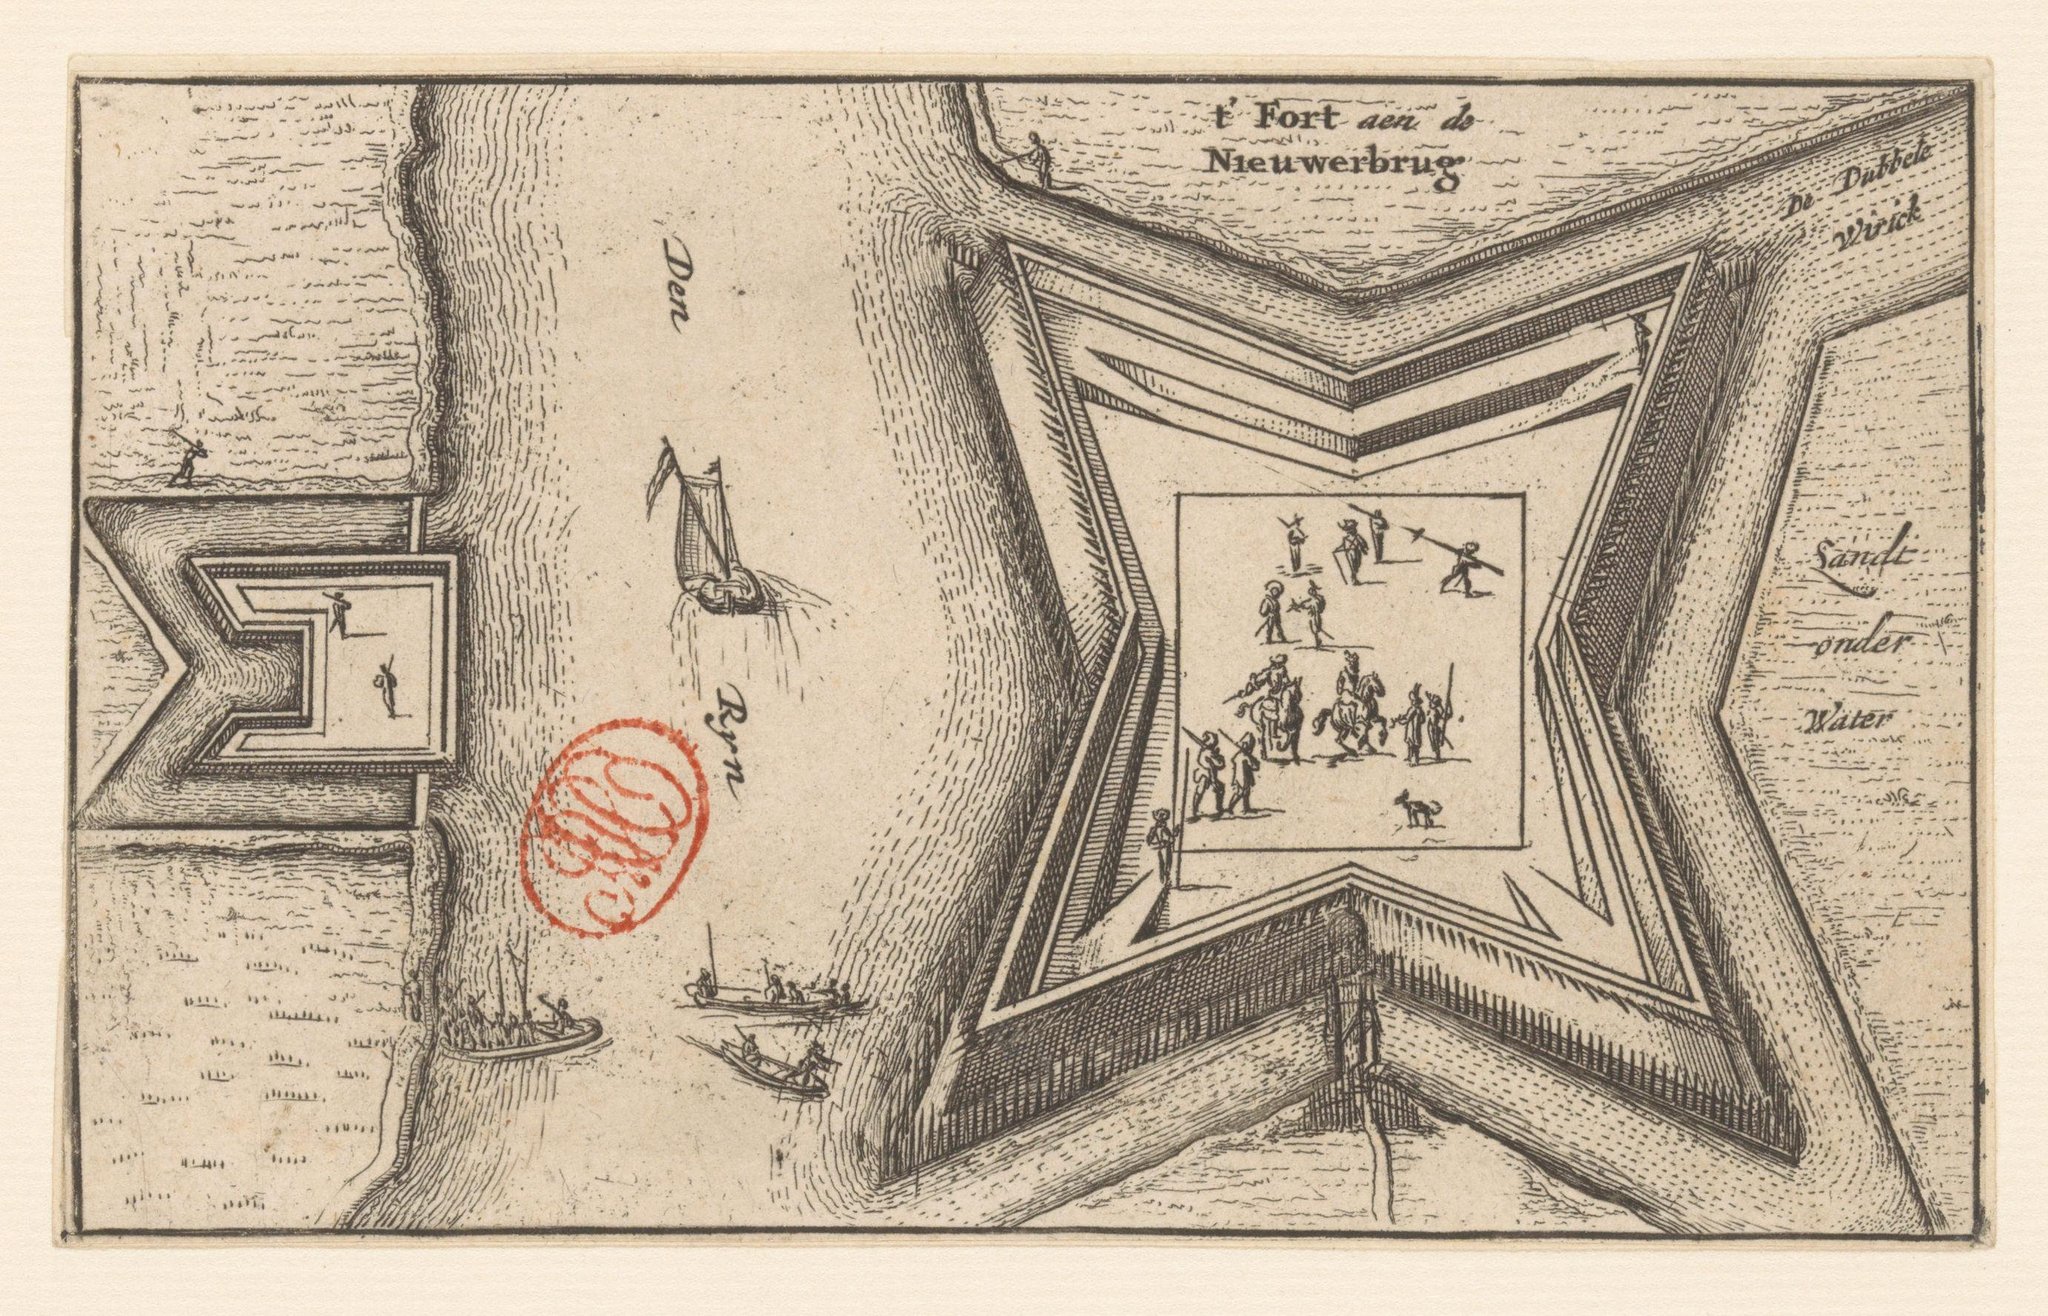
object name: print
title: t' Fort aen de Nieuwerbrug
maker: Anonymous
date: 1680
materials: paper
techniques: engraving, etching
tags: fortress, bastion, bulwark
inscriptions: collector's mark: Lugt 195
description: Deze vestingplattegrond is afgesneden van een prent met daarop vier vestingplattegronden (t' Fort aen de Utermeerse Sluys, t' Fort by den Hinderdam, t' Fort aen de Nieuwerbrug en t' Fort aen de Goudse Sluys). Voor de rest van de plattegronden zie RP-P-AO-8-58, RP-P-AO-8-71 en RP-P-AO-10-56. Als geheel is deze prent ook gebruikt in: Valckenier, Peter en Andreas Muller. Das verwirrte Europa (…). 3 delen. Amsterdam: Hendrik en Dirk Boom, Joannes van Someren en Jacob van Meurs, 1677-1683, deel 2 (Des verwirreten Europæ Continuation (…), 1680).